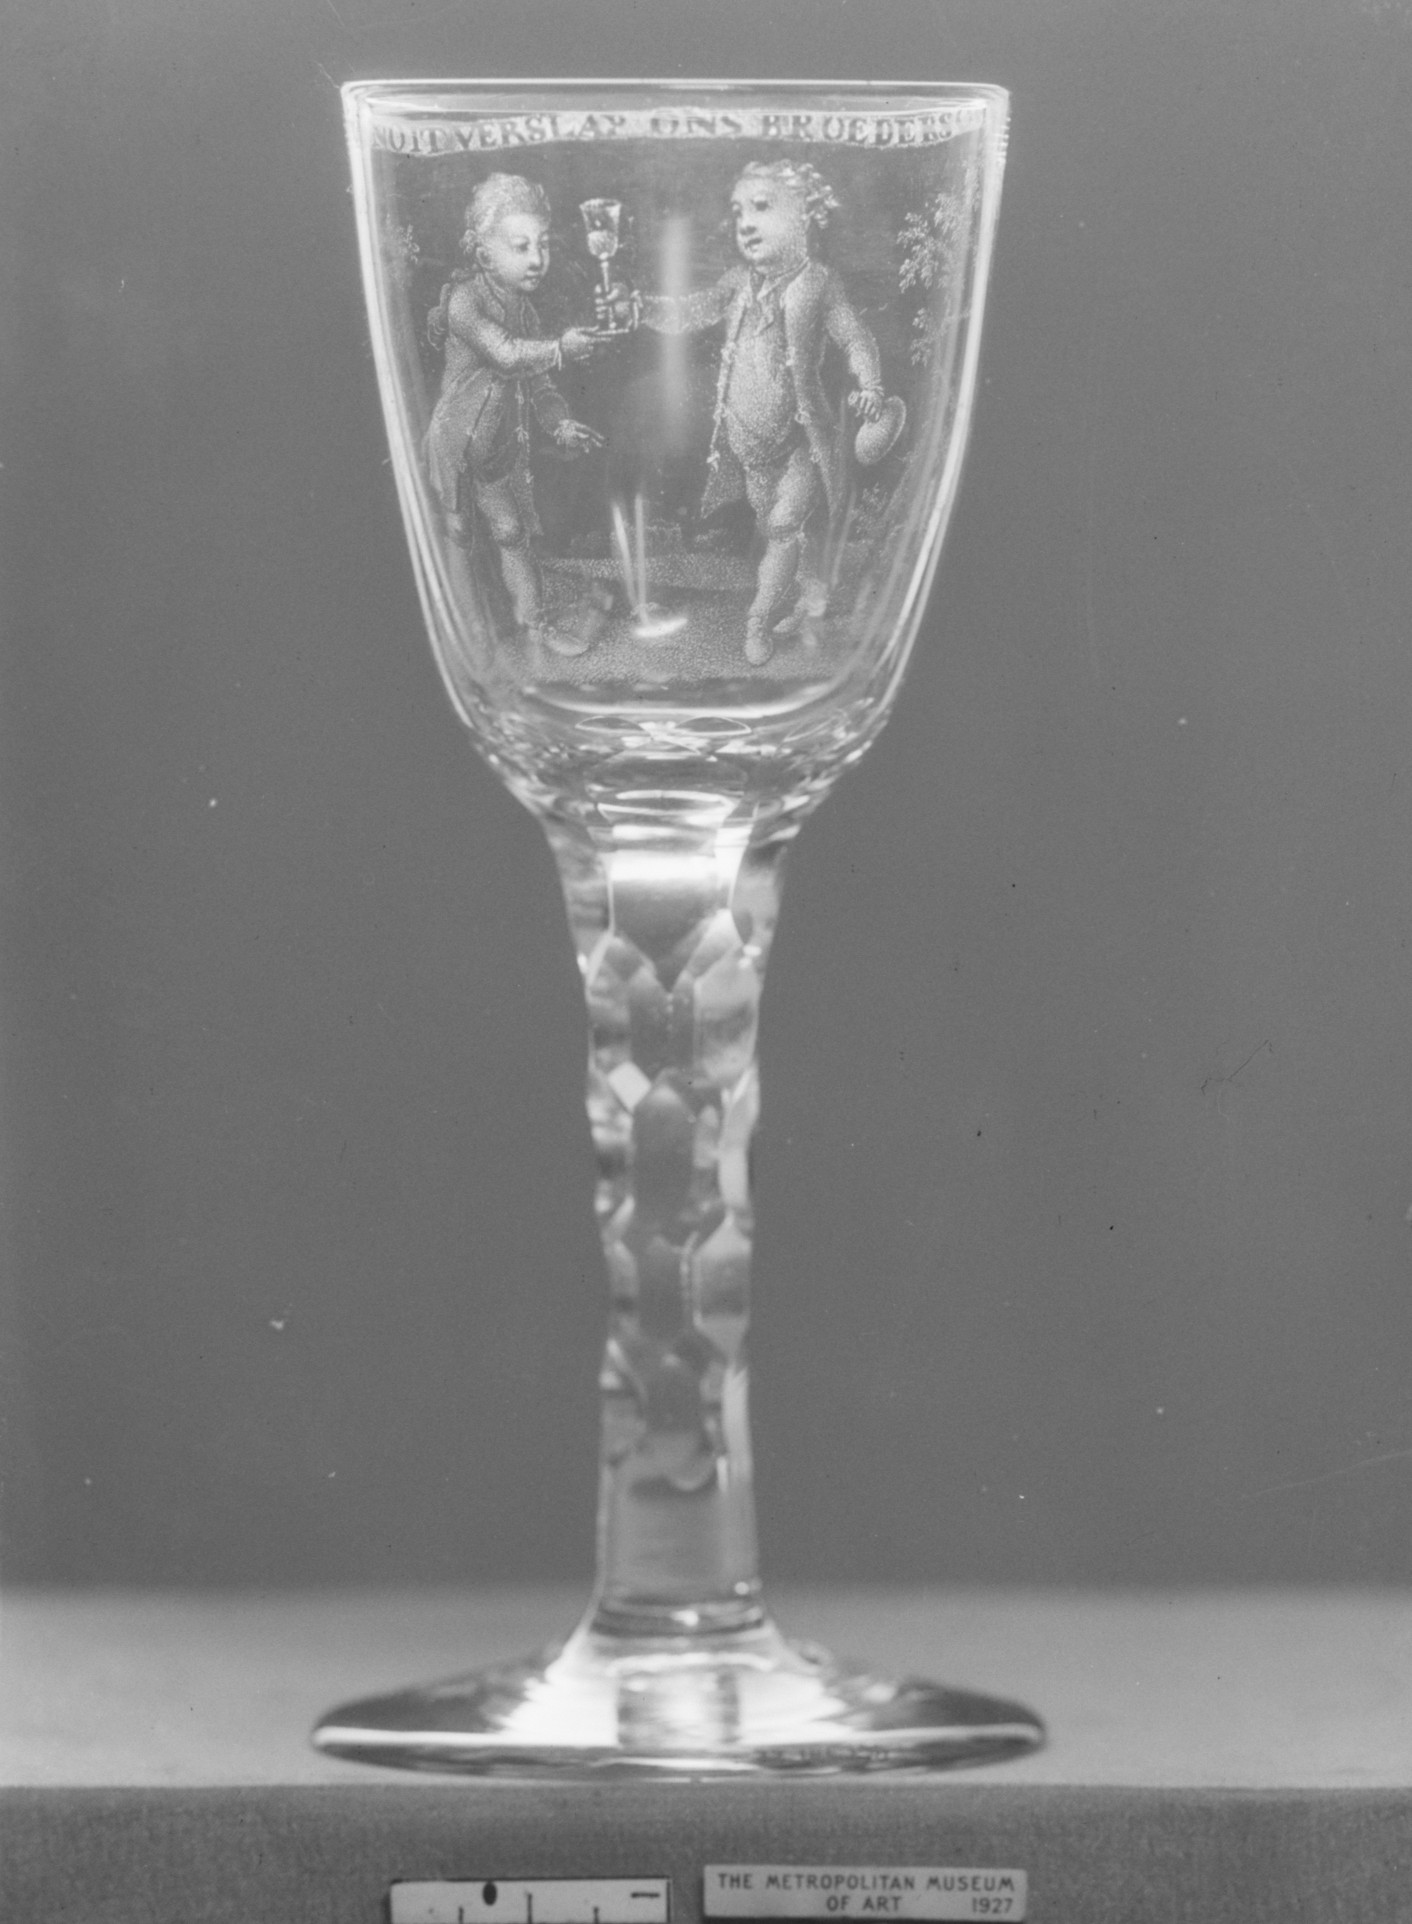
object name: wineglass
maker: david wolff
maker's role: engraver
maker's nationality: dutch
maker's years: 1732-1798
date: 1785-1790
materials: glass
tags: men,women,drinking